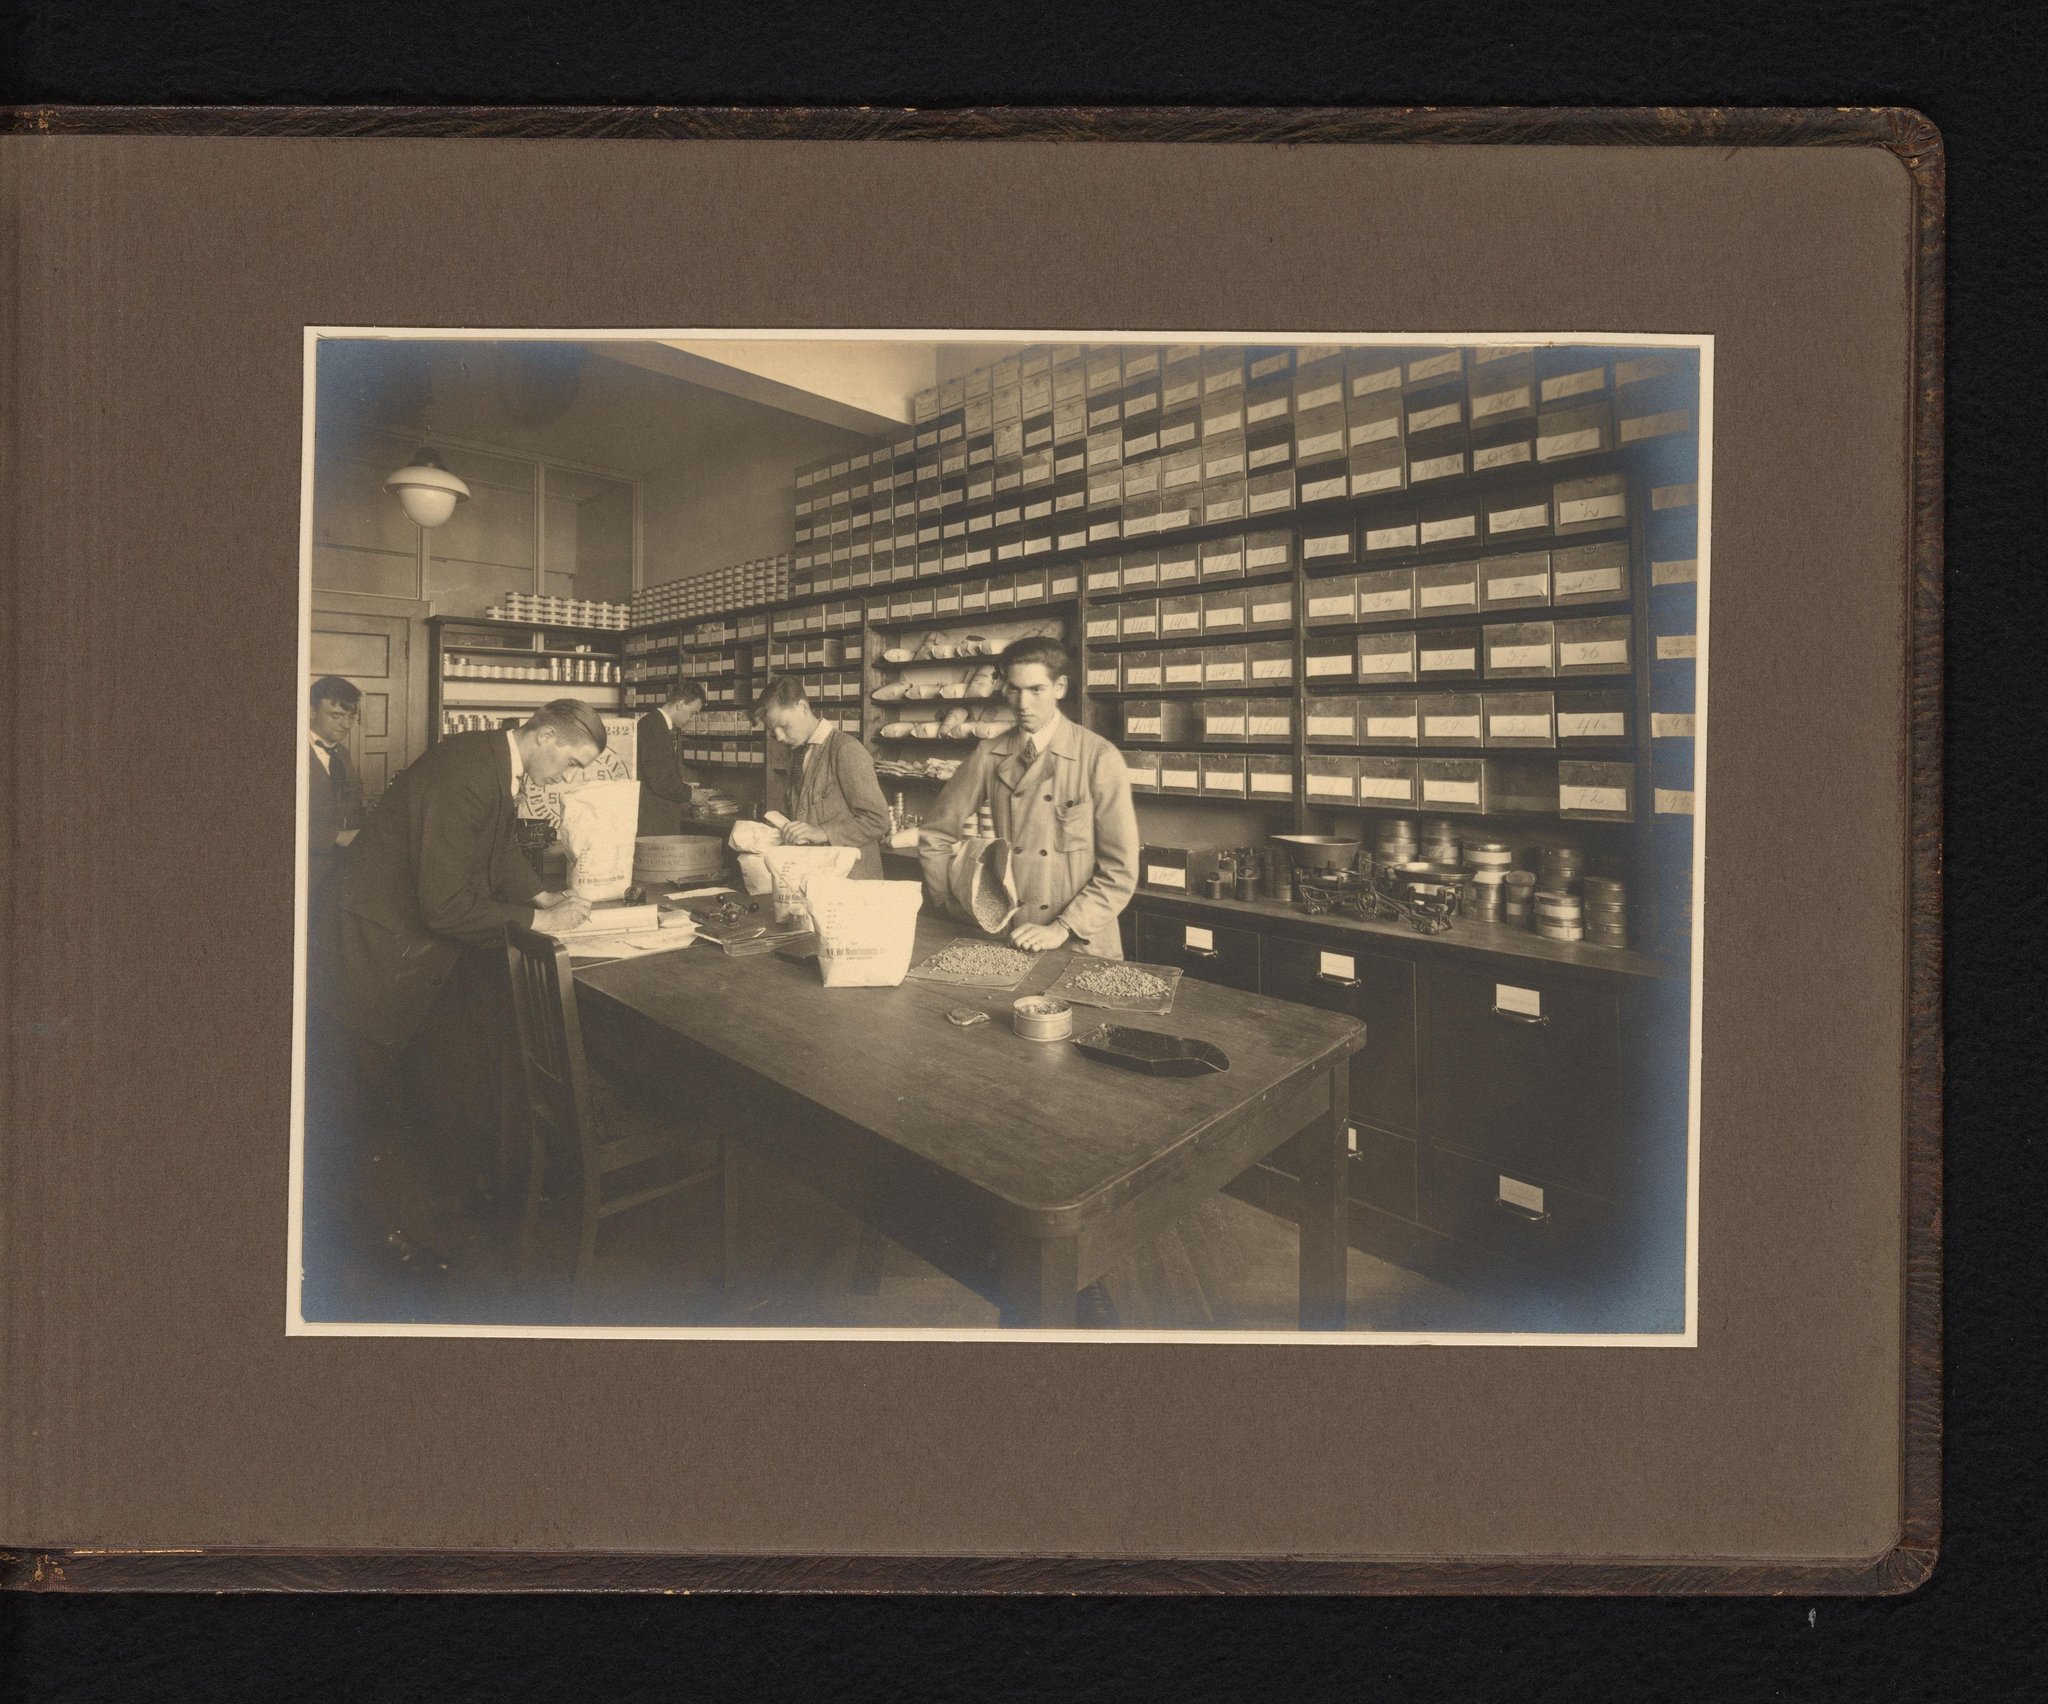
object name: photograph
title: Vijf mannen werkzaam in een pakhuis, vermoedelijk N.V. Het Nederlandsche Veem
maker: Anonymous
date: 1900-1930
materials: cardboard, paper, photographic support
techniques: gelatin silver print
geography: amsterdam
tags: large-scale structure for storage, e.g.: warehouse, depot, silo, adult man (+ five persons), amsterdam